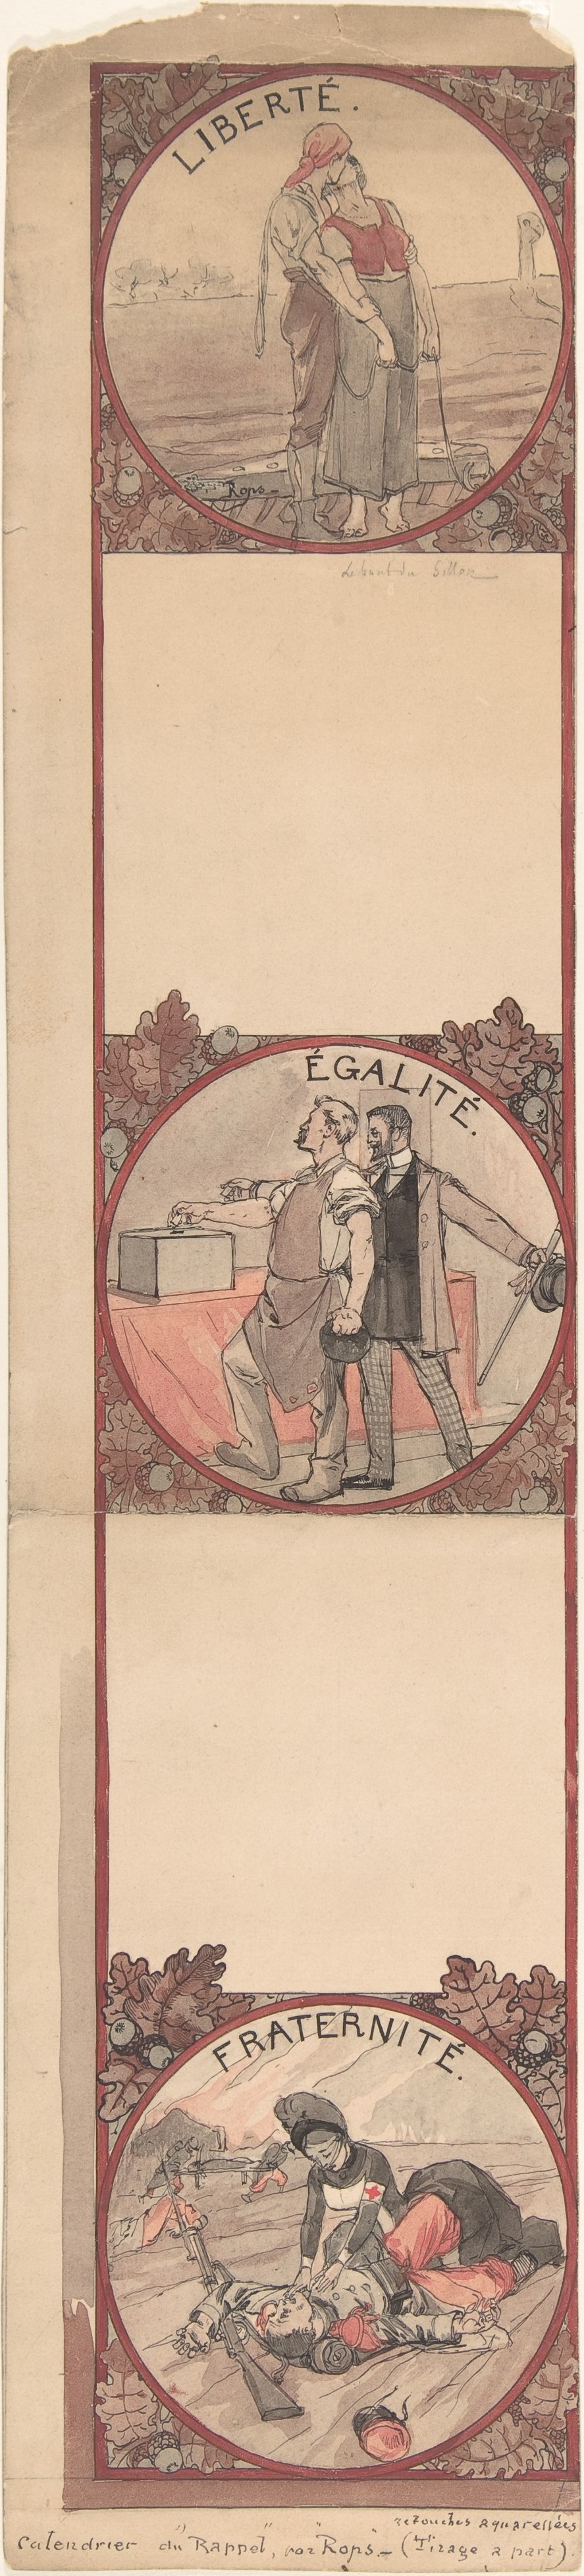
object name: drawing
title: Liberté, Egalité, Fraternité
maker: félicien rops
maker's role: artist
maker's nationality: belgian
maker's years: 1833-1898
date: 1833-1898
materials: ink, watercolor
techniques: pen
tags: firearms,men,women